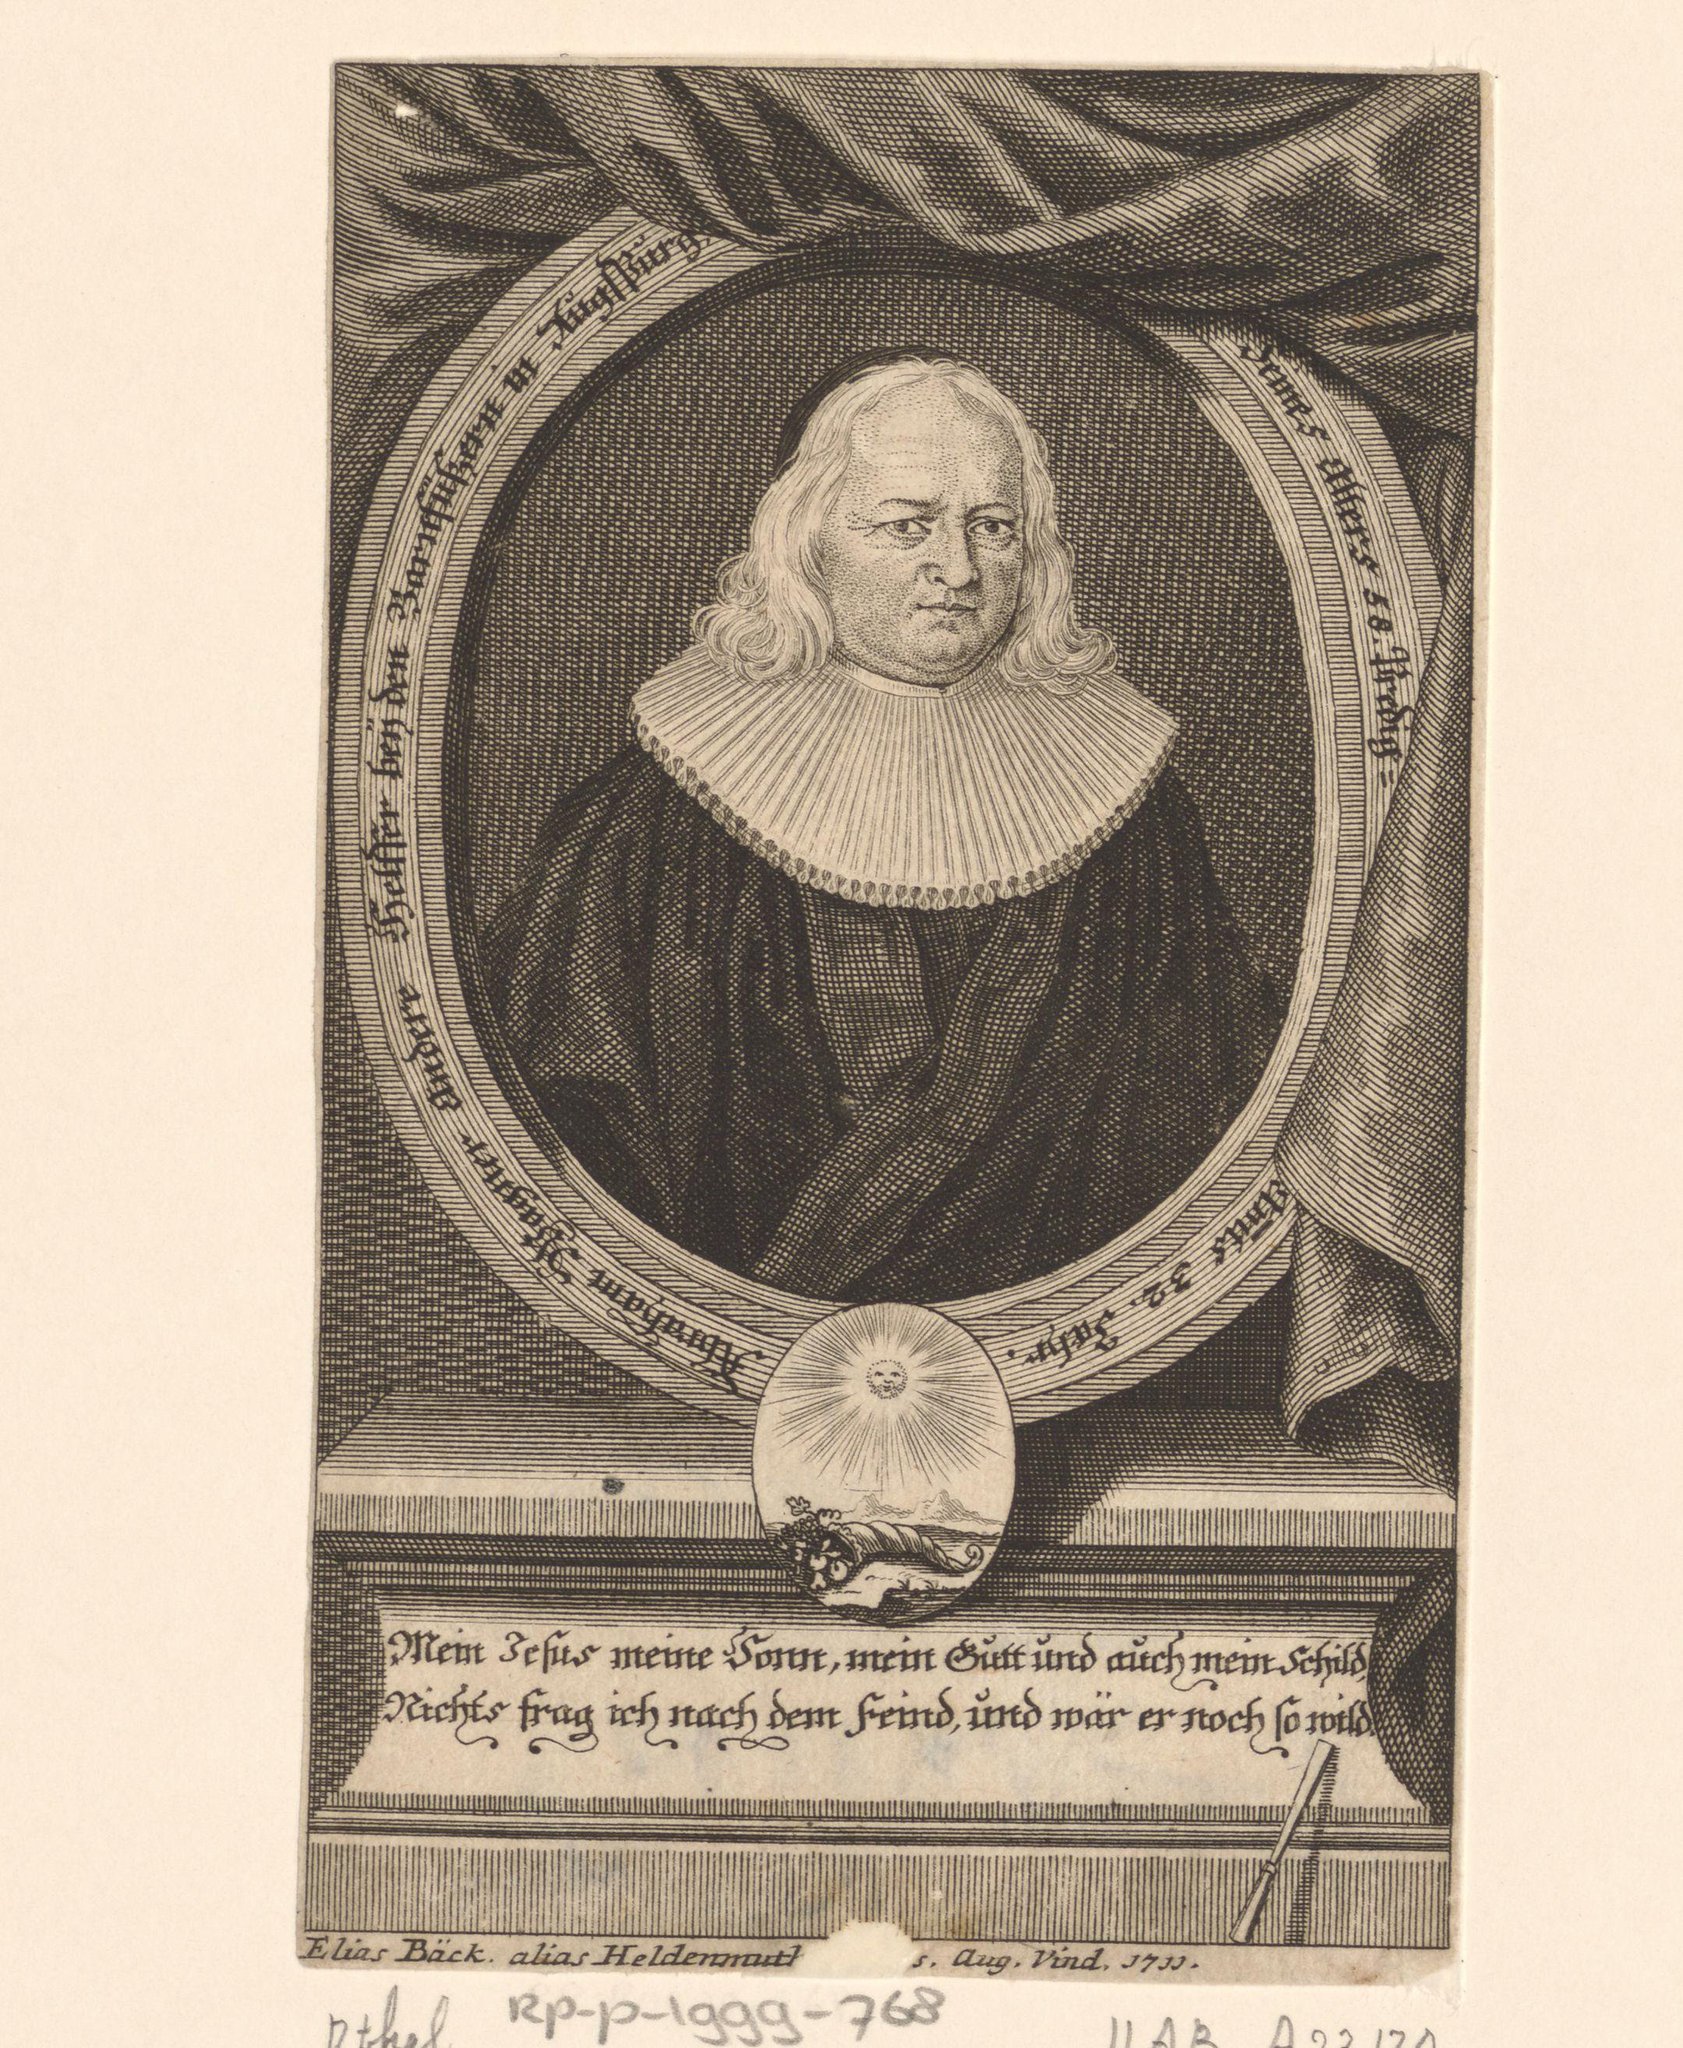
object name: print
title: Portret Abraham Wagner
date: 1711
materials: paper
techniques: engraving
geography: augsburg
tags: abraham wagner (1653-1728), 'cornucopia', horn of plenty, theologian, historical persons, portrait of a musician, armorial bearing, heraldry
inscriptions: collector's mark: Lugt 2228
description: Portret van Abraham Wagner (1653-1728): theoloog, mathematicus en musicus. Buste in toga, naar rechts, in ovaal met draperie erboven. Midden onder ovaal schild met afbeelding van een zon en hoorn van overvloed. Duits gedicht op sokkel waarin Jezus wordt vergeleken met de zon en een schild.